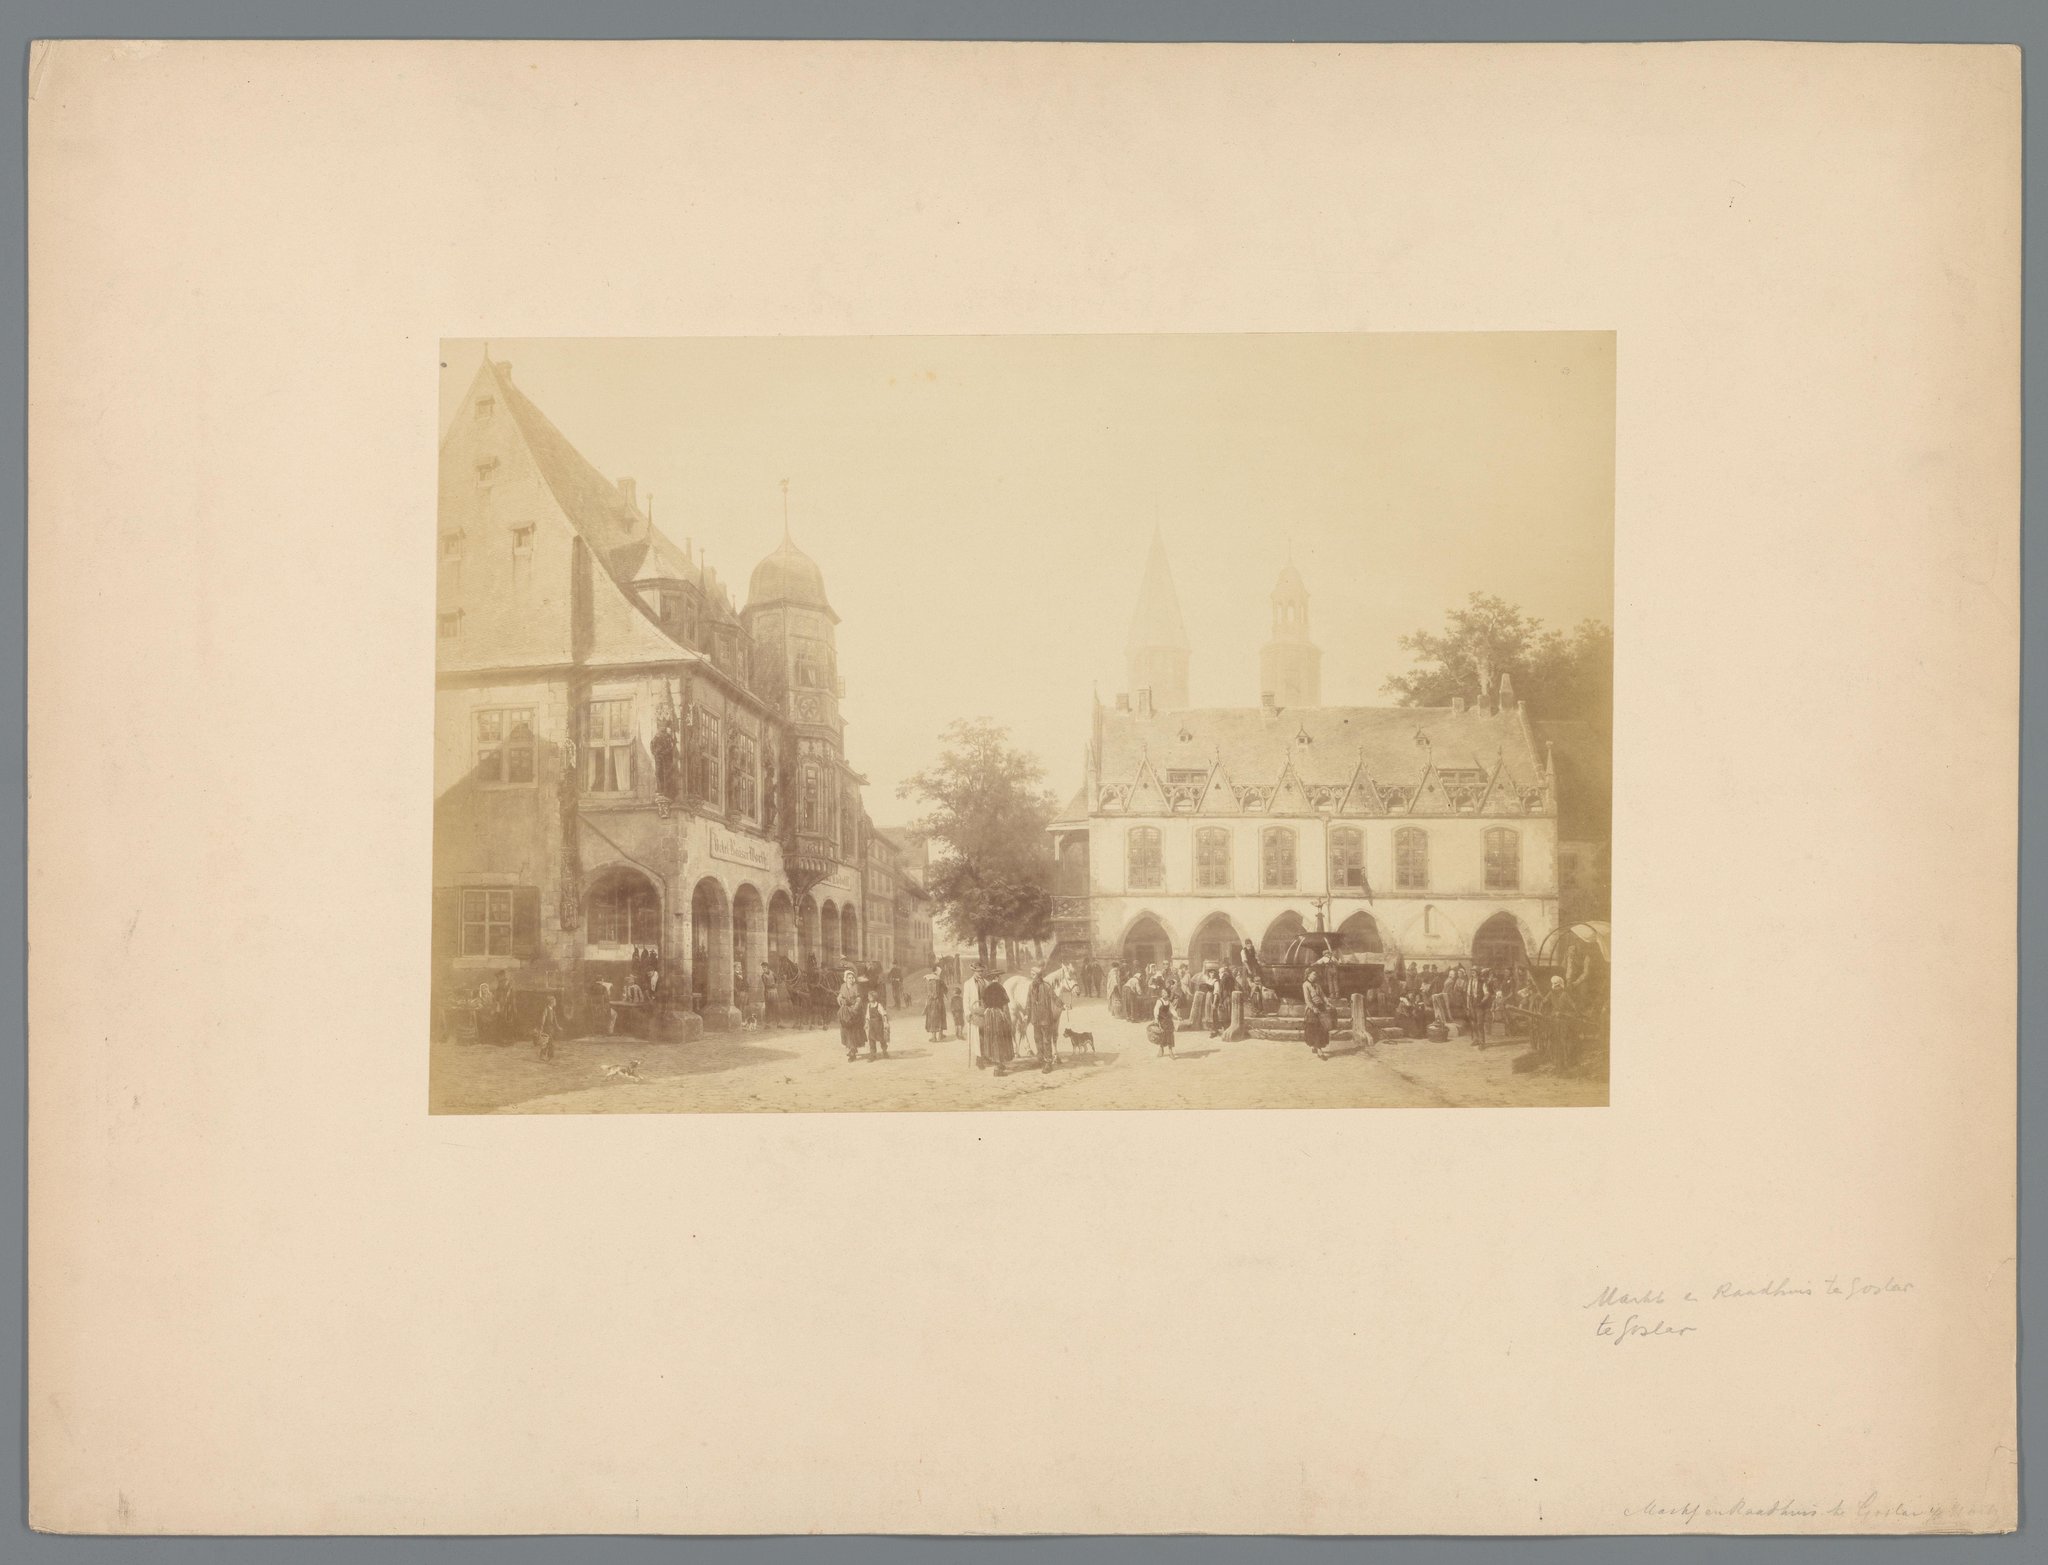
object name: reproduction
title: Fotoreproductie van een schilderij voorstellende de markt en het raadhuis van Goslar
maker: Anonymous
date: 1851-1900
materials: cardboard, paper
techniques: albumen print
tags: townhall, picture, painting, market, parts of church exterior and annexes: tower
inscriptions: inscription: ‘Markt en Raadhuis te Goslar/ te Goslar/ Markt en Raadhuis te Goslar’, bookplate: ‘EX/ LIBRIS/ I/S’